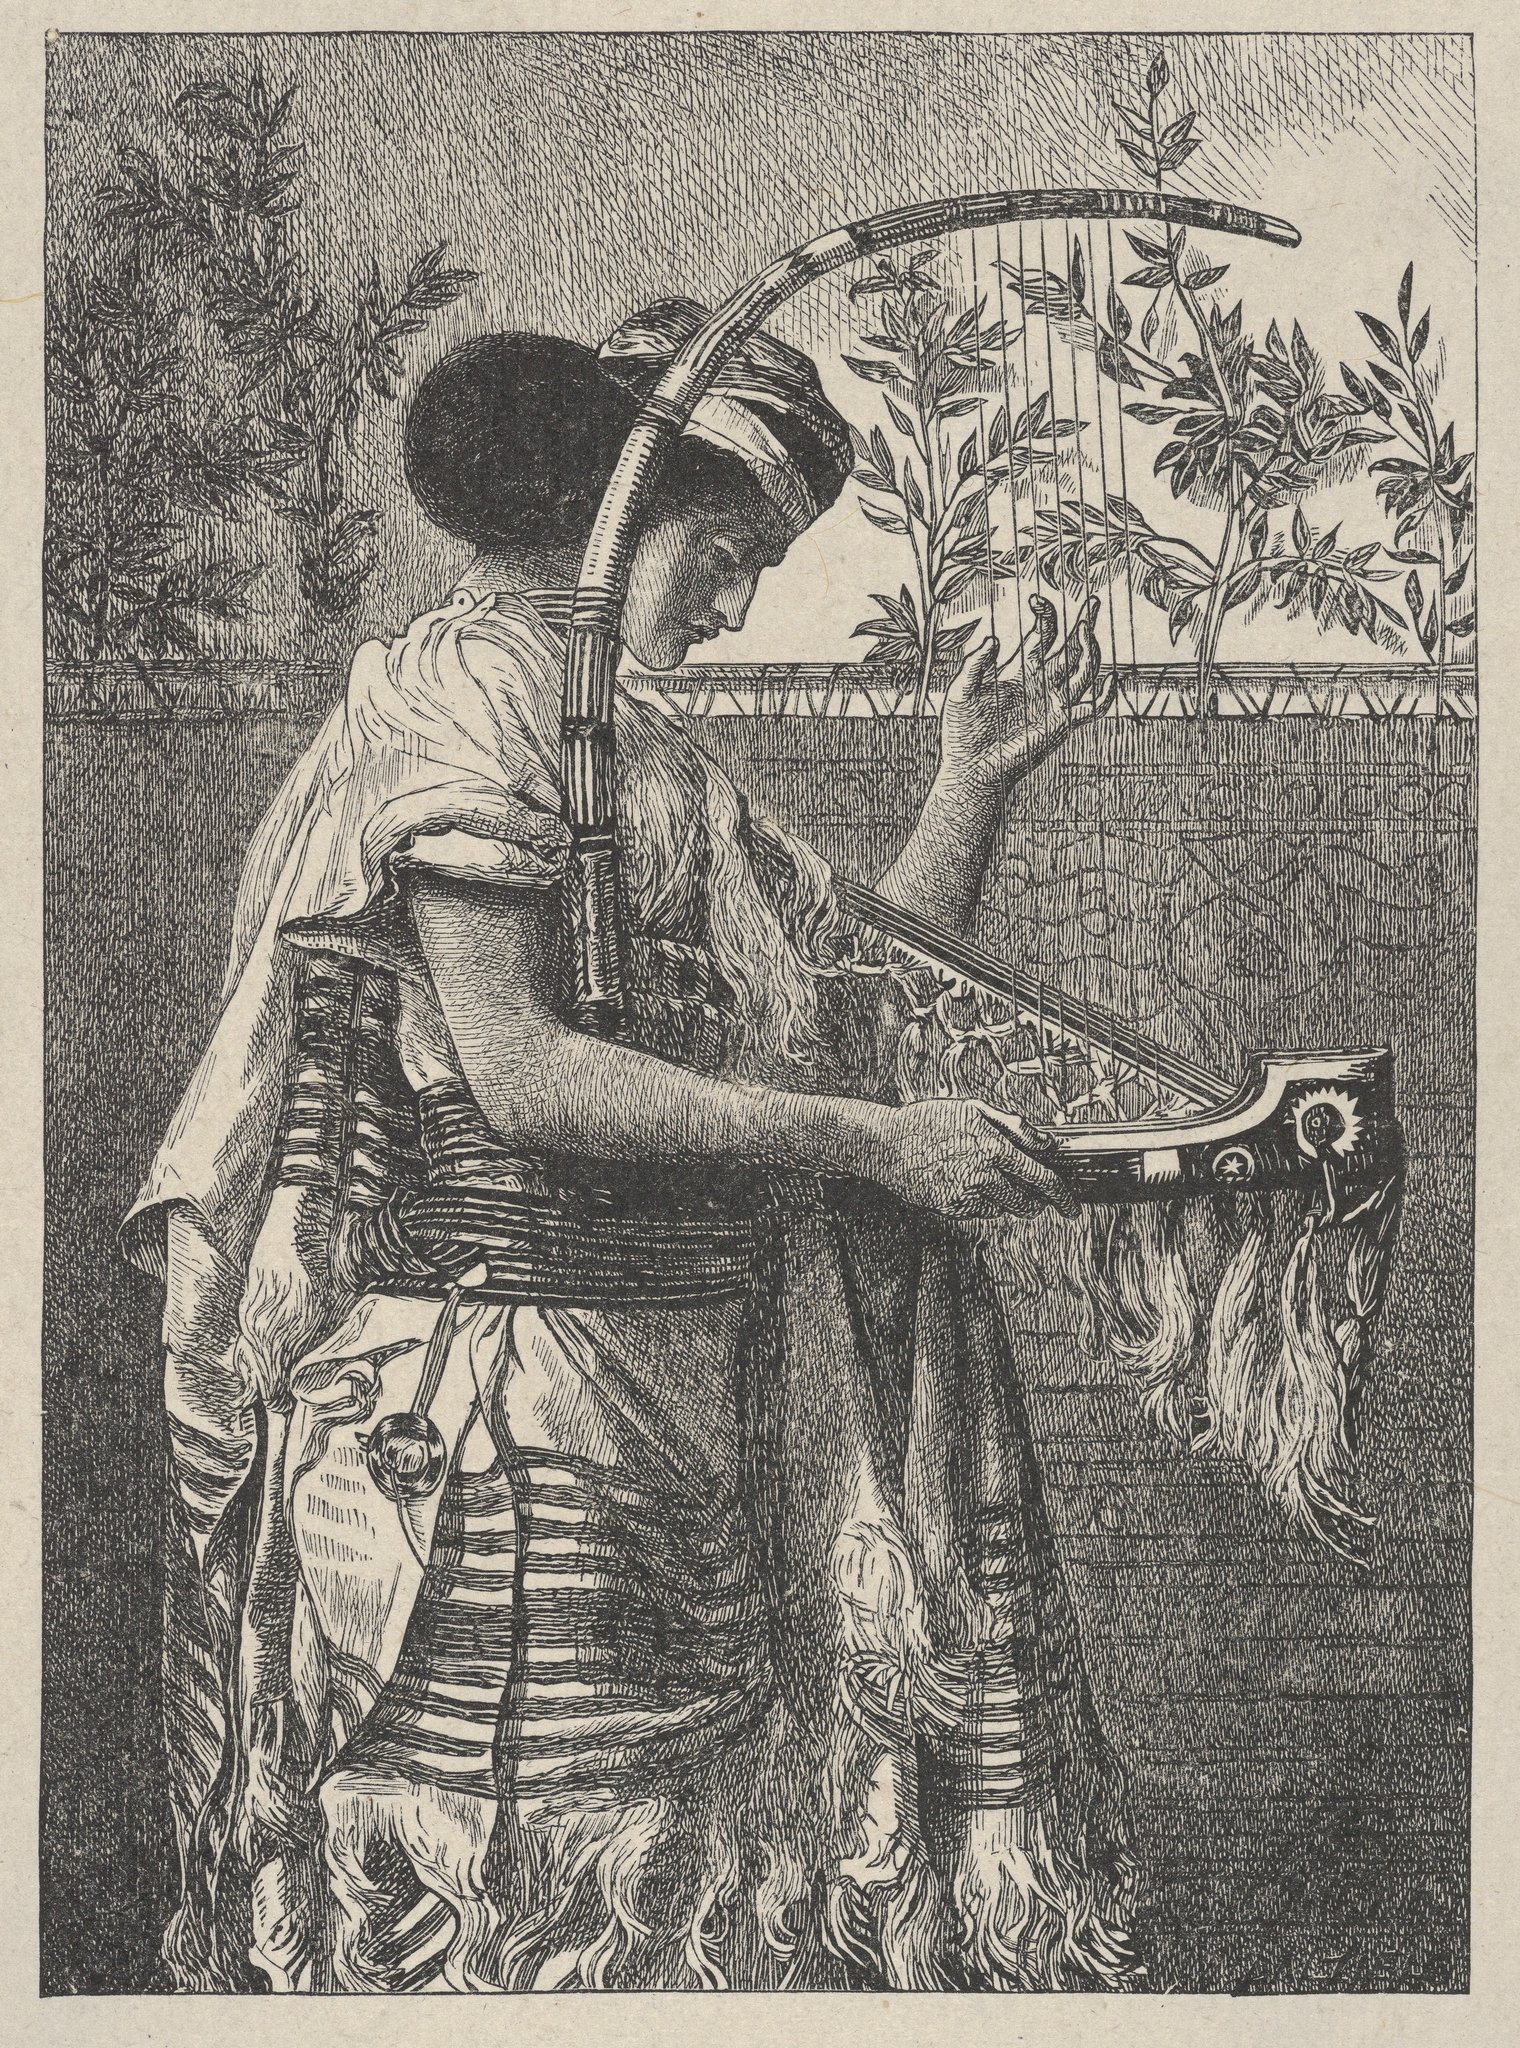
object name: print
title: Hosannah!, from "Dalziels' Bible Gallery"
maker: simeon solomon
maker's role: artist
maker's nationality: british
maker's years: 1840-1905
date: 1863-1881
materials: paper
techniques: engraving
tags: musical instruments,profiles,women